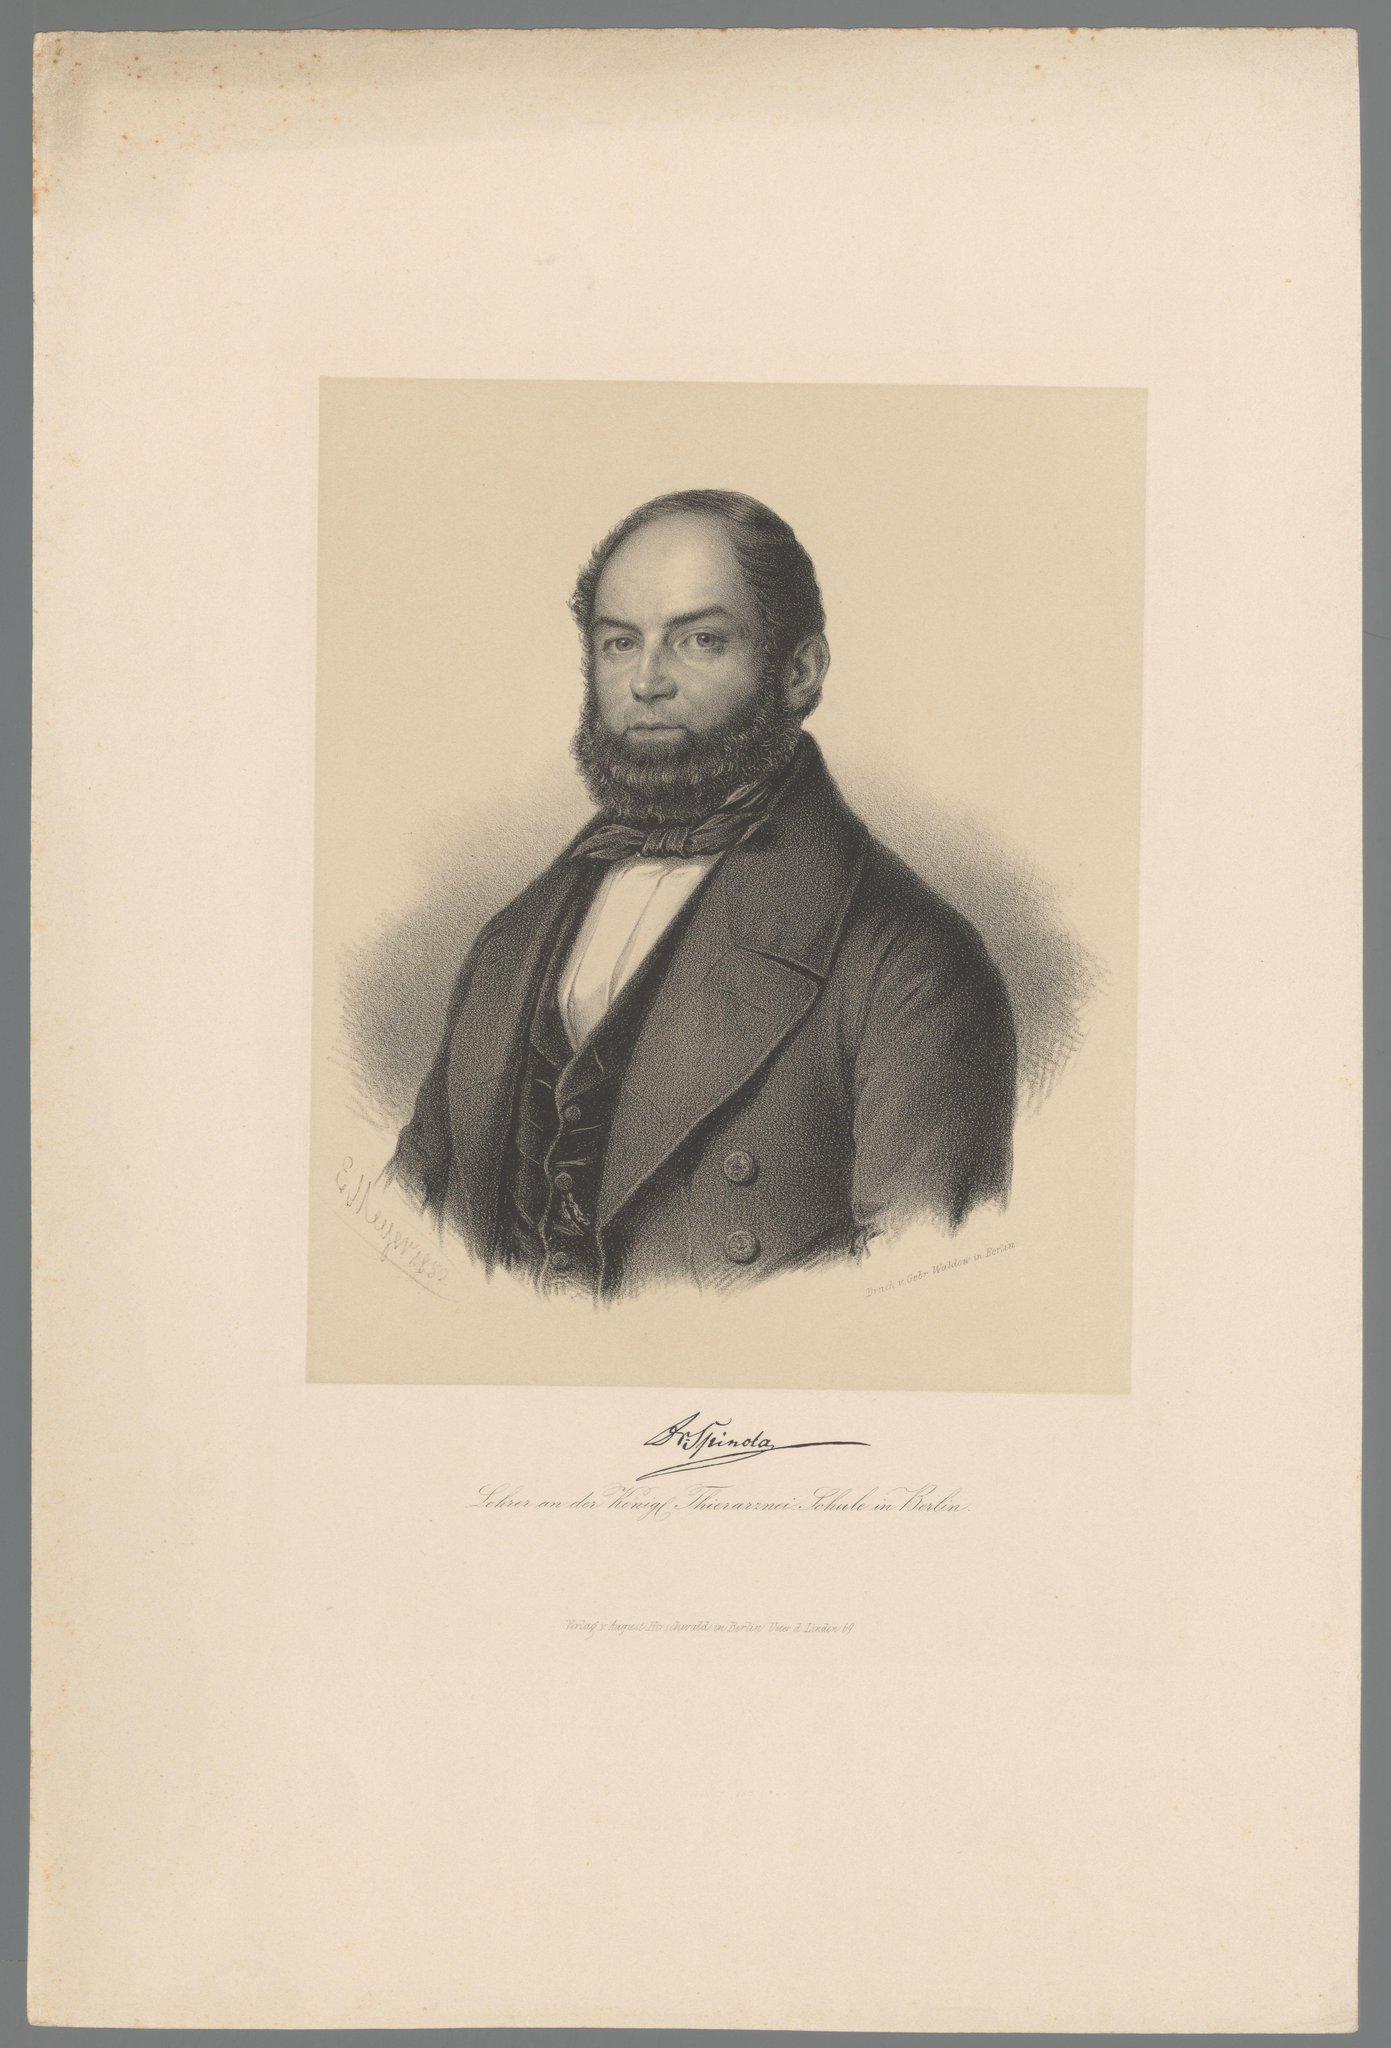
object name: print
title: Portret van een onbekende man, mogelijk W.T.J. Spinola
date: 1852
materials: paper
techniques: lithograph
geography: berlin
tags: adult man, historical persons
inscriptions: collector's mark: Lugt 2228